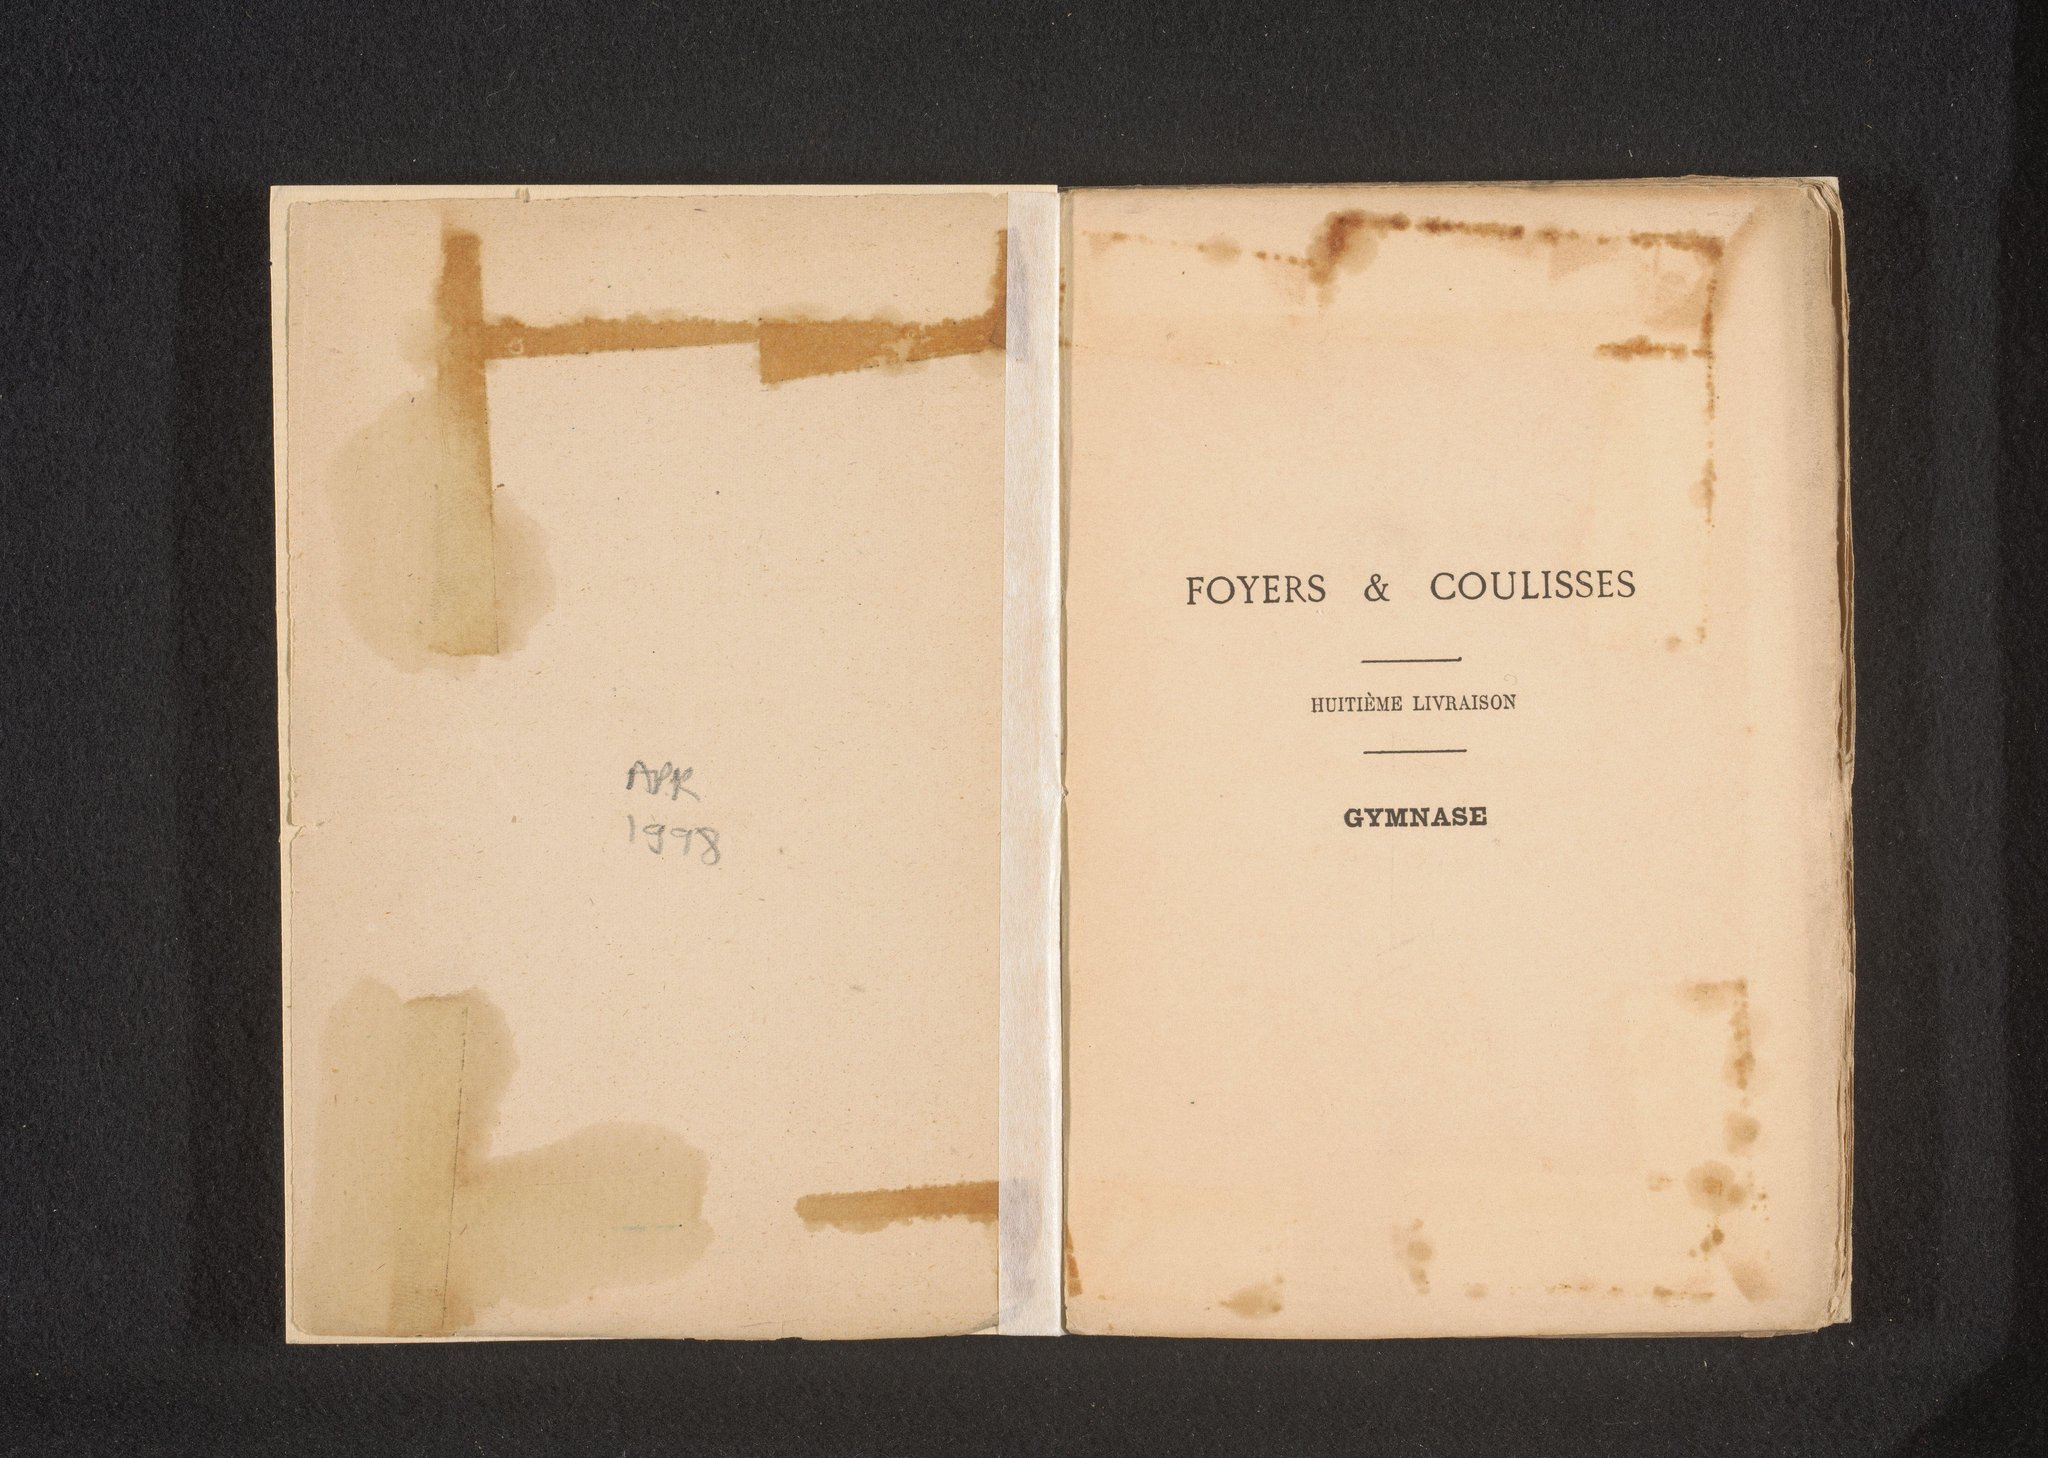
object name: book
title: Foyers et coulisses : histoire anecdotique des théatres de Paris : Gymnase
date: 1875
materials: paper, photographic support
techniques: albumen print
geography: clichy